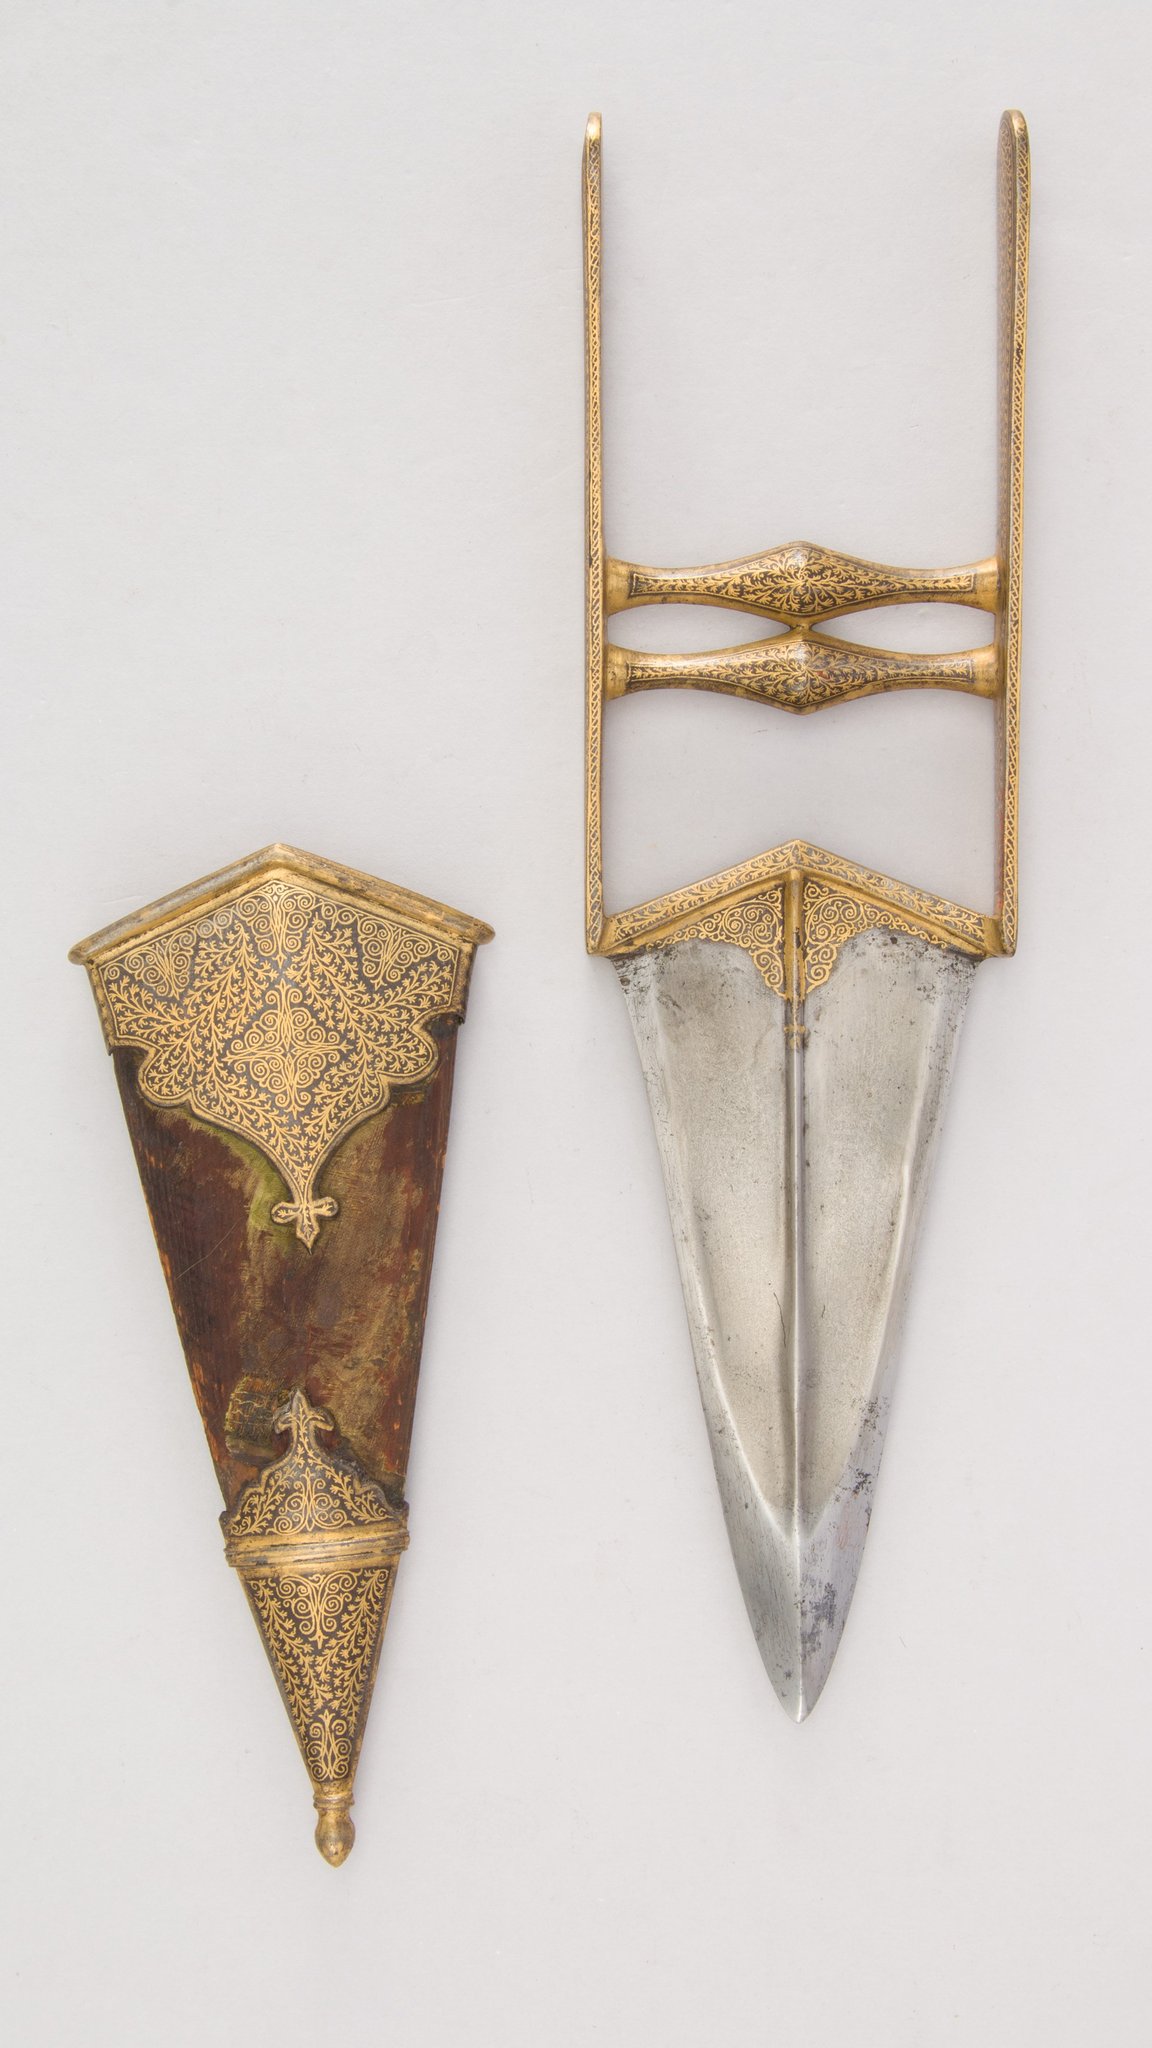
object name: dagger with sheath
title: Dagger (Katar) with Sheath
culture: indian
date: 1701-1900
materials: gold, steel, velvet, wood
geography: north india